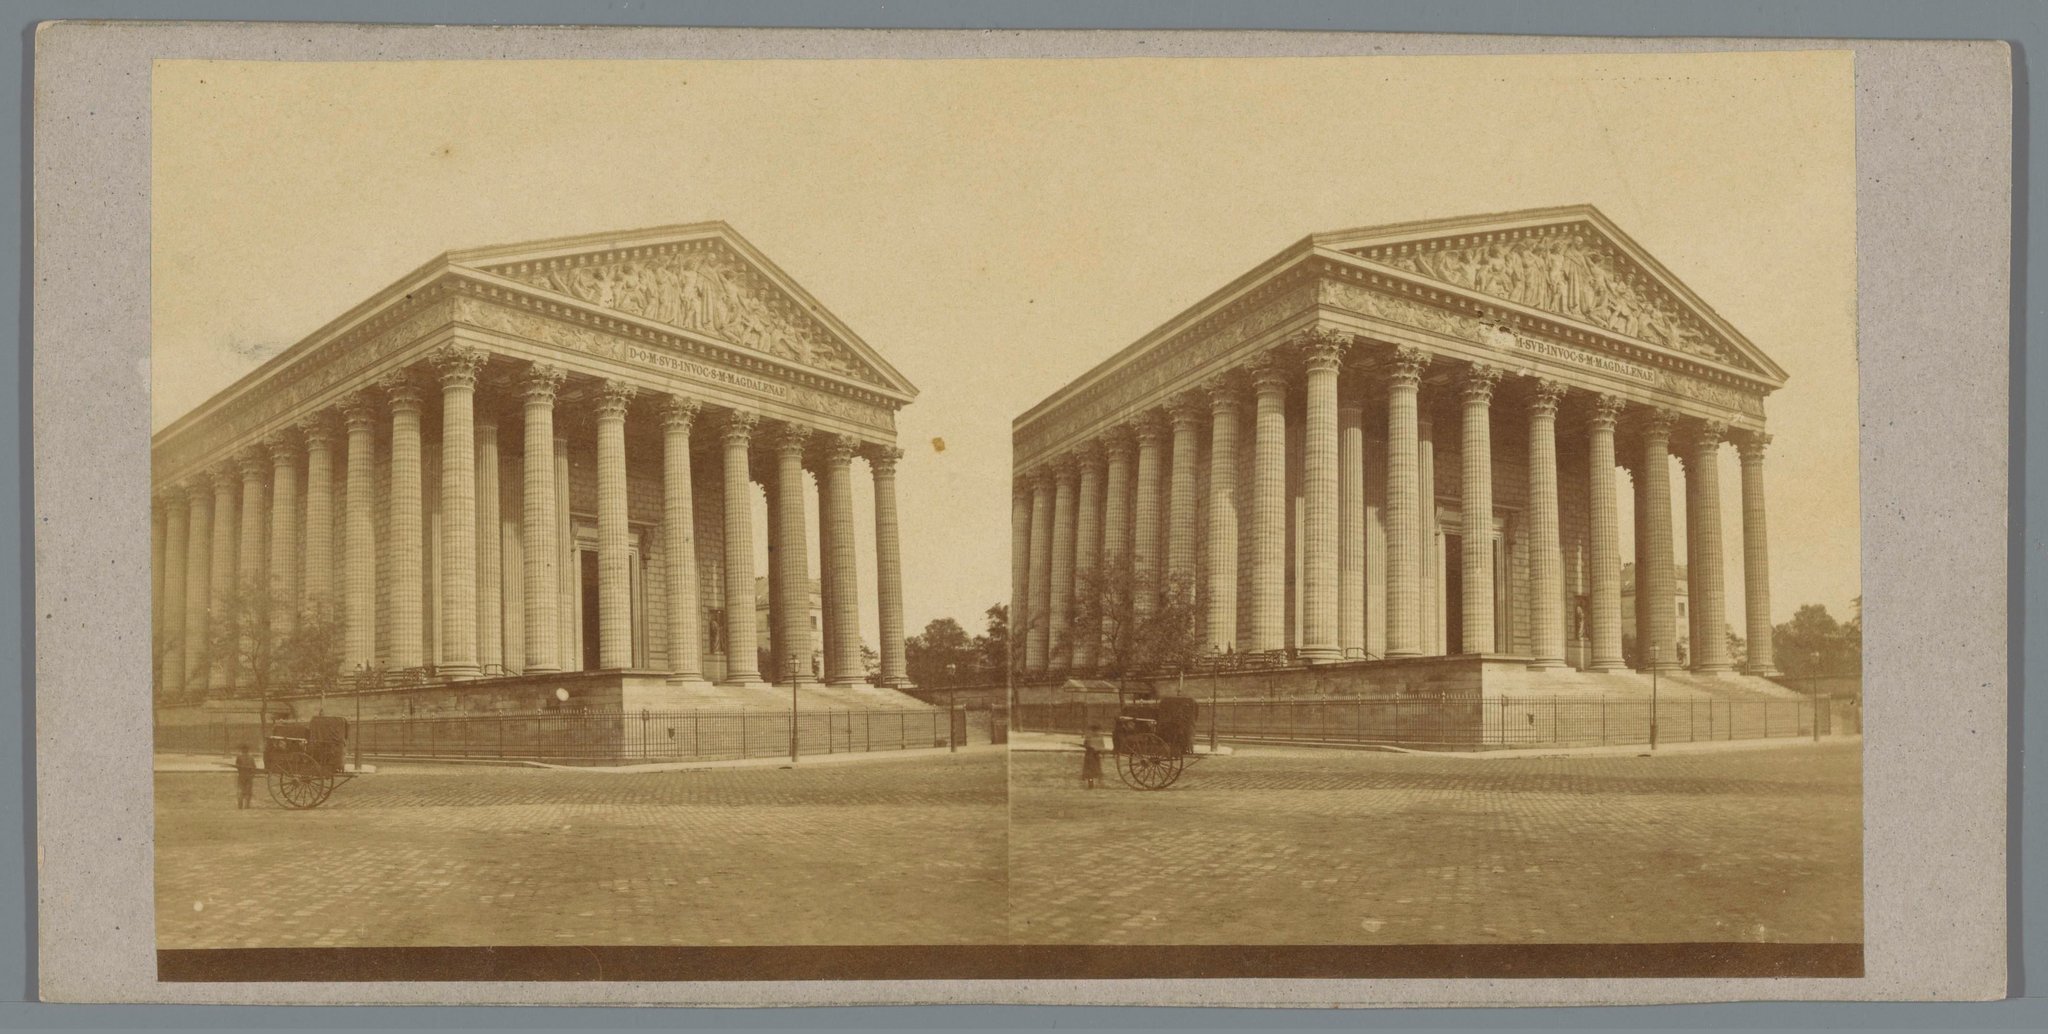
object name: stereograph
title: Gezicht op La Madeleine in Parijs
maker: Anonymous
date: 1860-1865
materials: cardboard, photographic support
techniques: albumen print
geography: paris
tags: two-wheeled, animal-drawn vehicle, parts of church exterior and annexes: façade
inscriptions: number: ‘P. 8.’, inscription: ‘Madeleine’